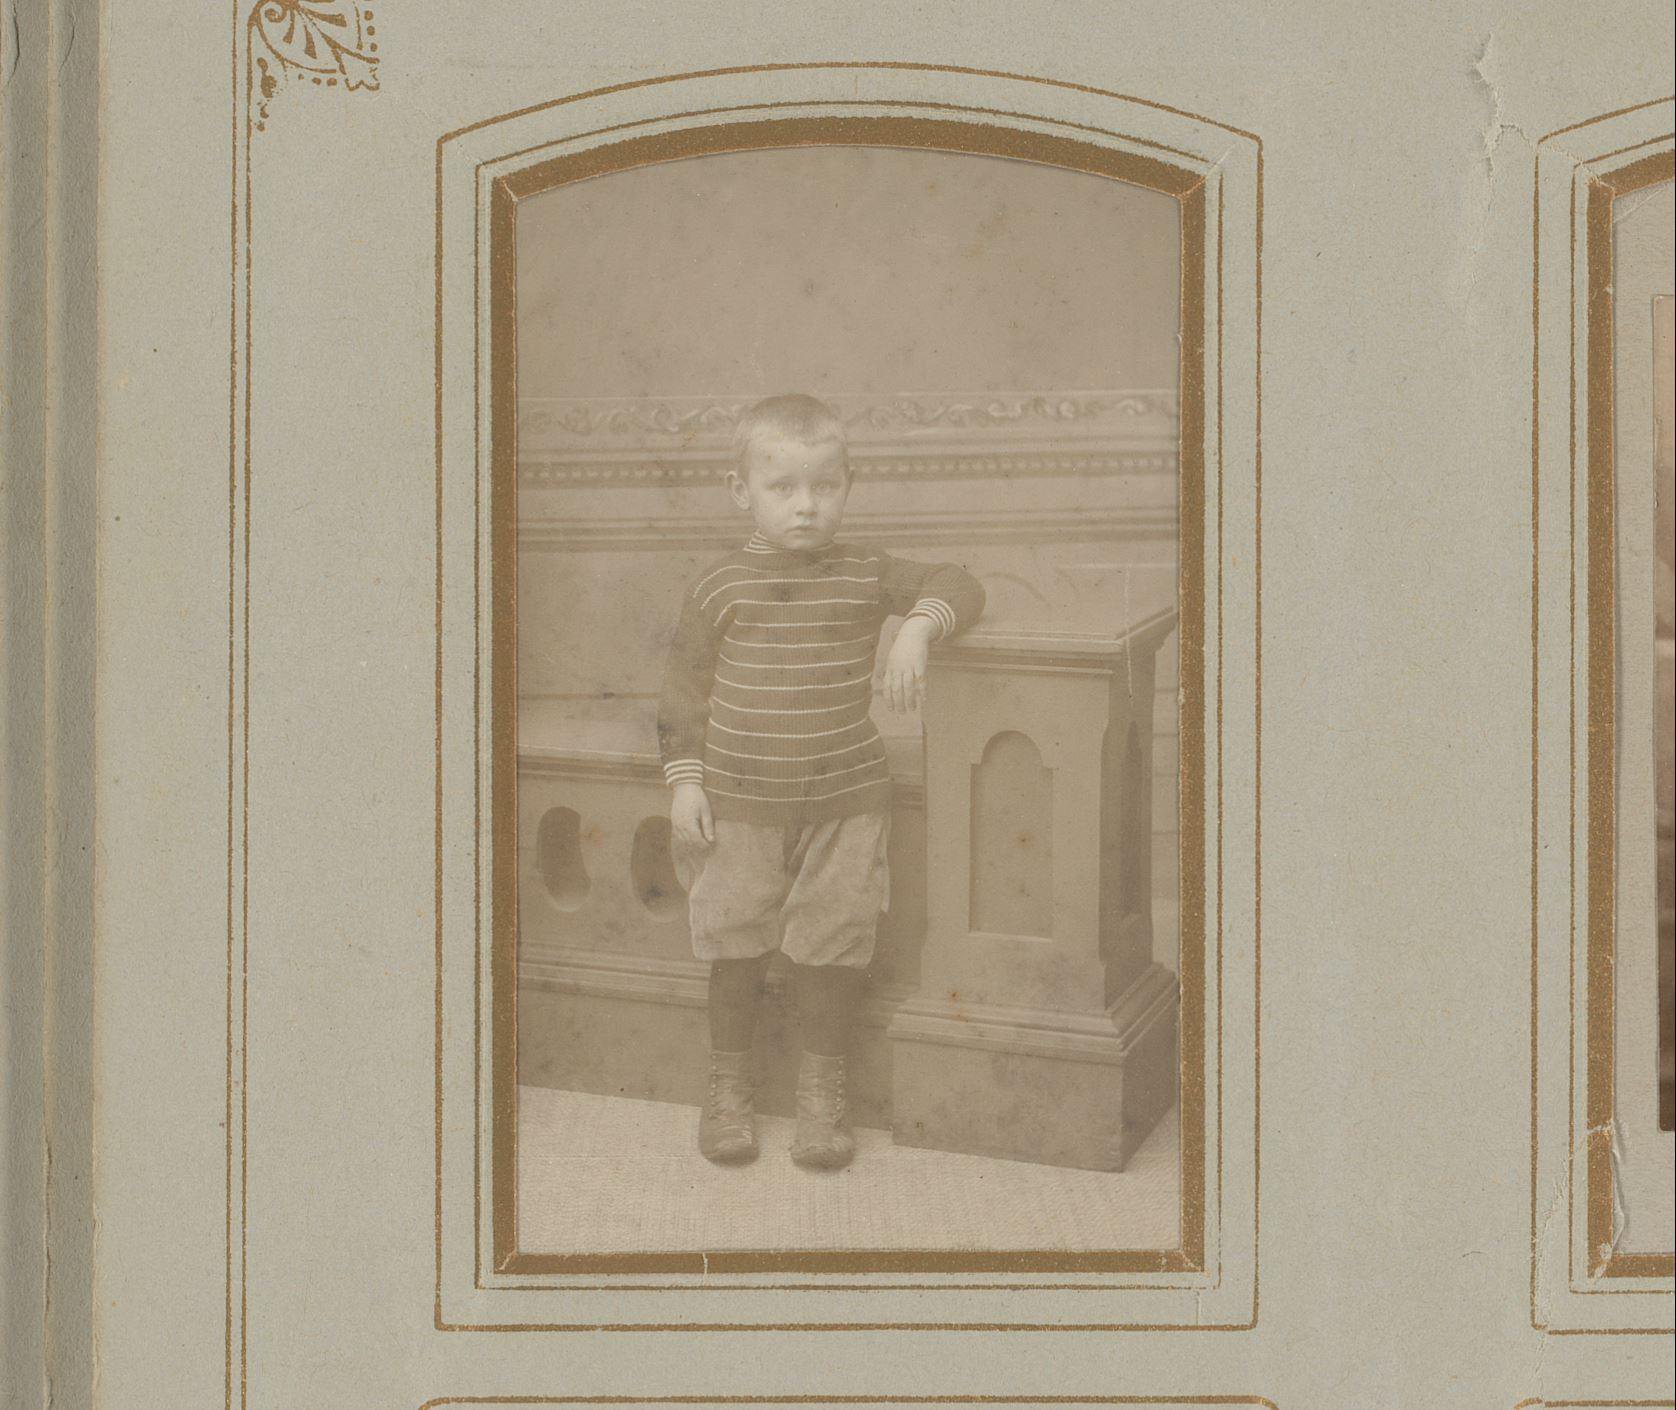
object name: photograph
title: Portret van een jongen, staand bij een zuil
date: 1895-1920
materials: cardboard, photographic support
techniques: matte daylight collodion silver print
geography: edam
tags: historical persons, toddler (male), pedestal of a piece of sculpture (perhaps in the form of a herm)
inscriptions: inscription: ‘Atélier Siewers/ EDAM.’